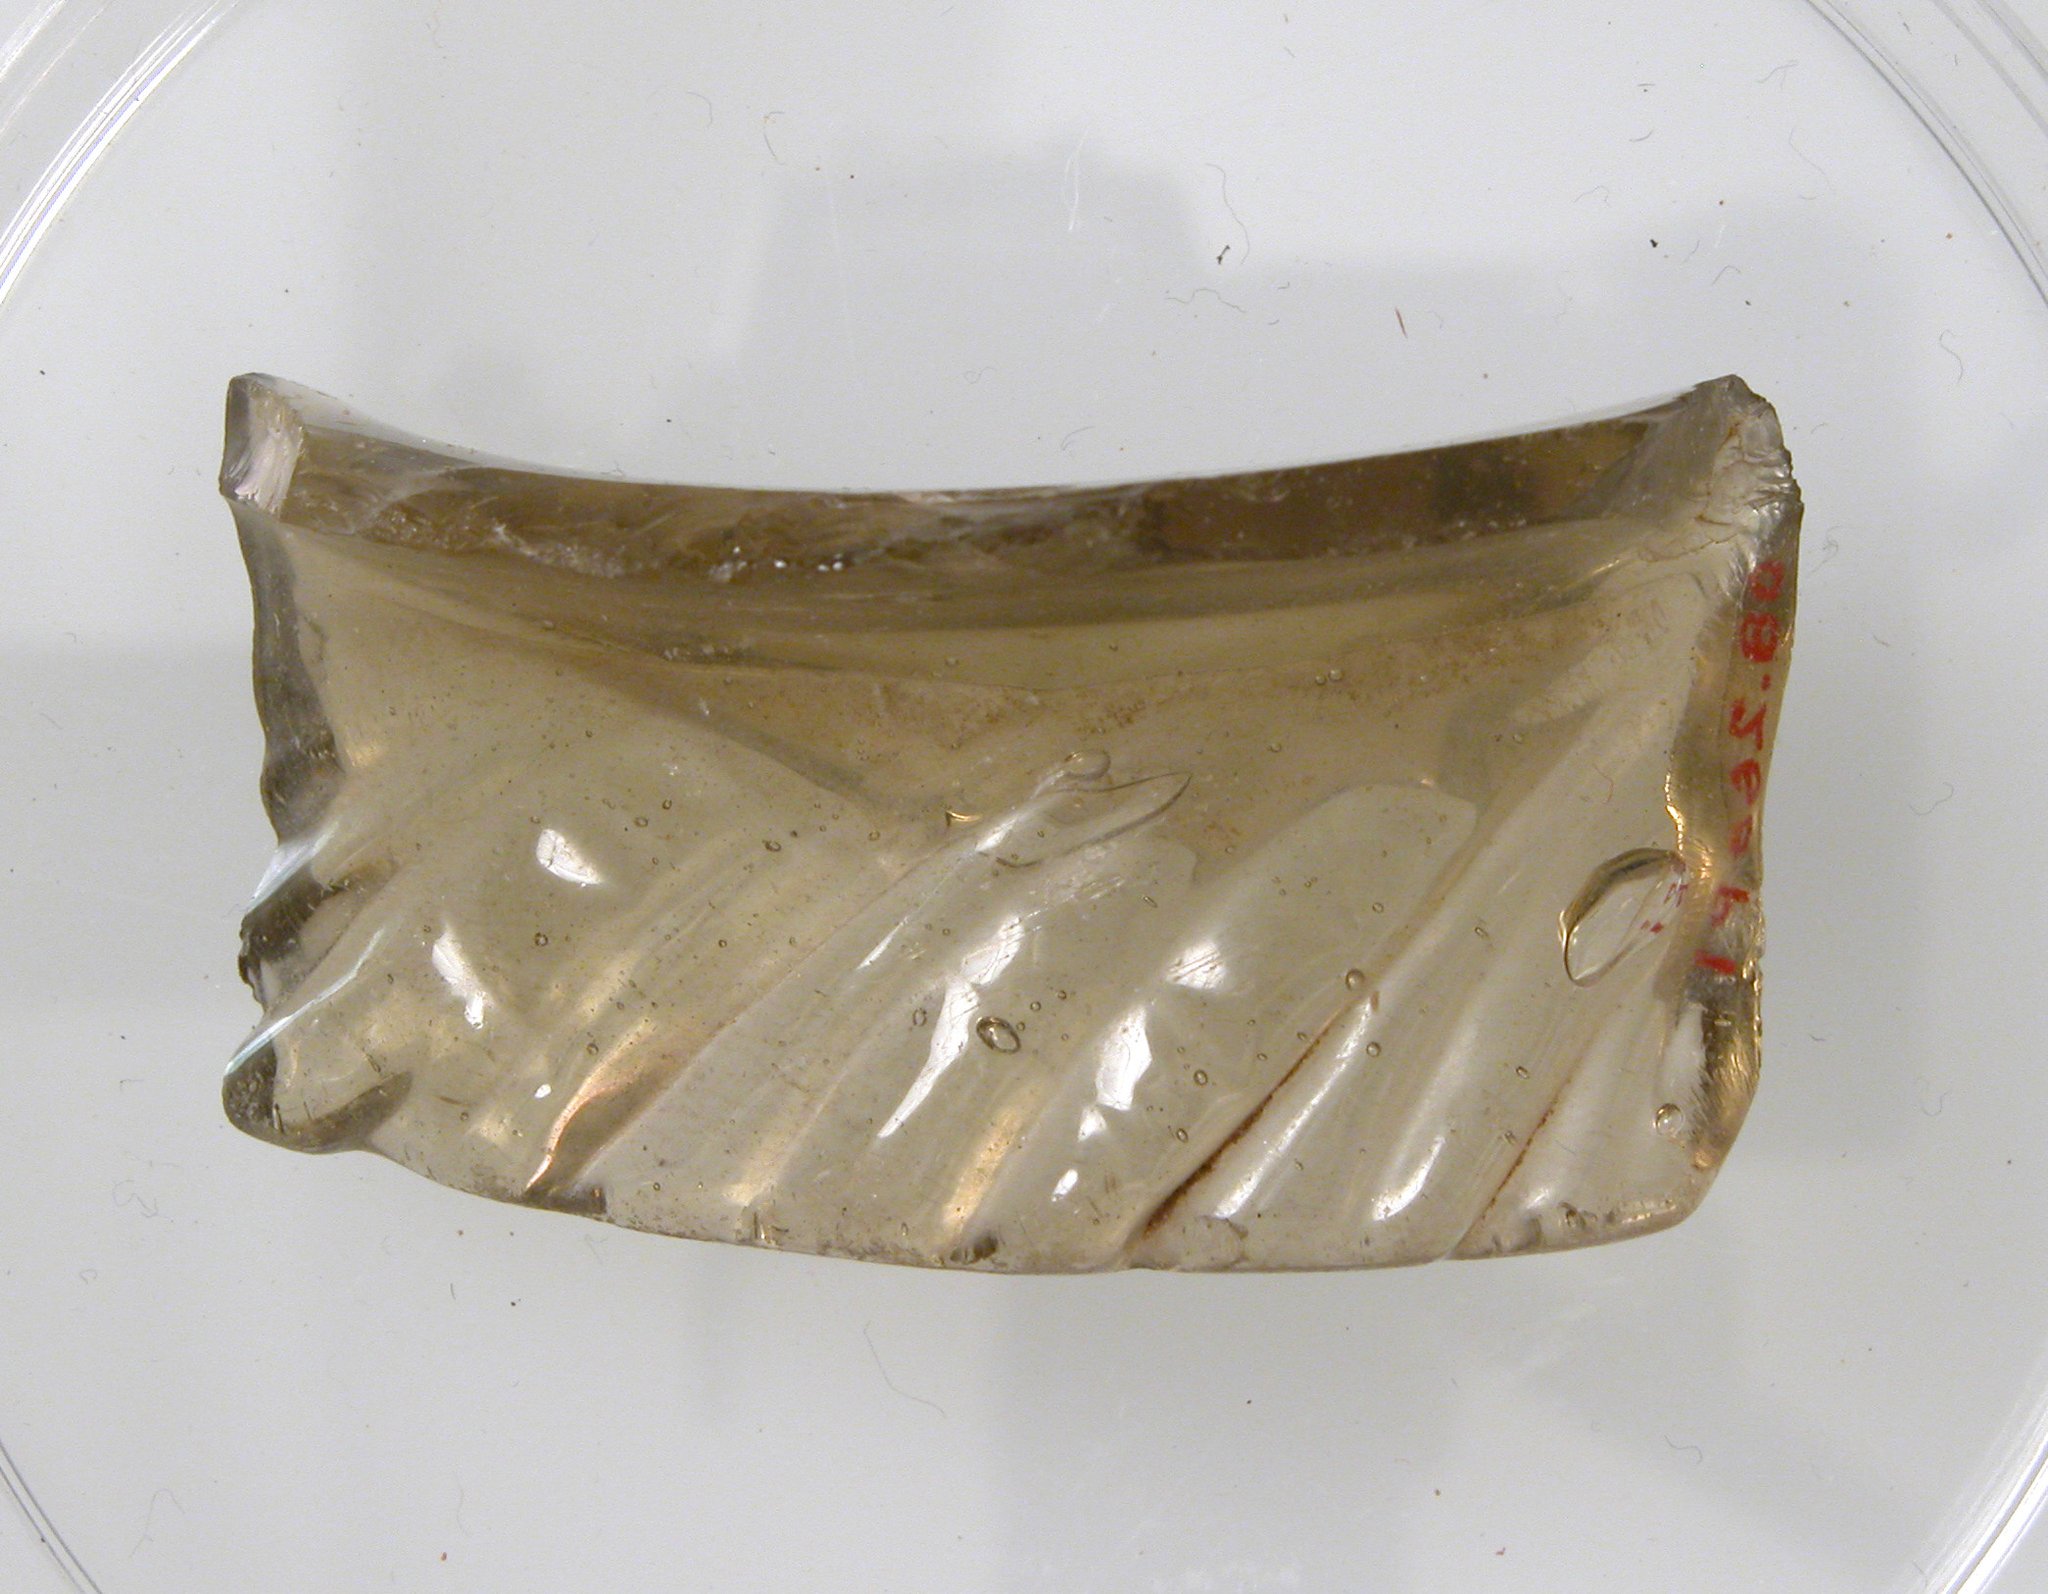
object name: fragment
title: Glass Fragment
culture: coptic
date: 301-433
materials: glass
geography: egypt